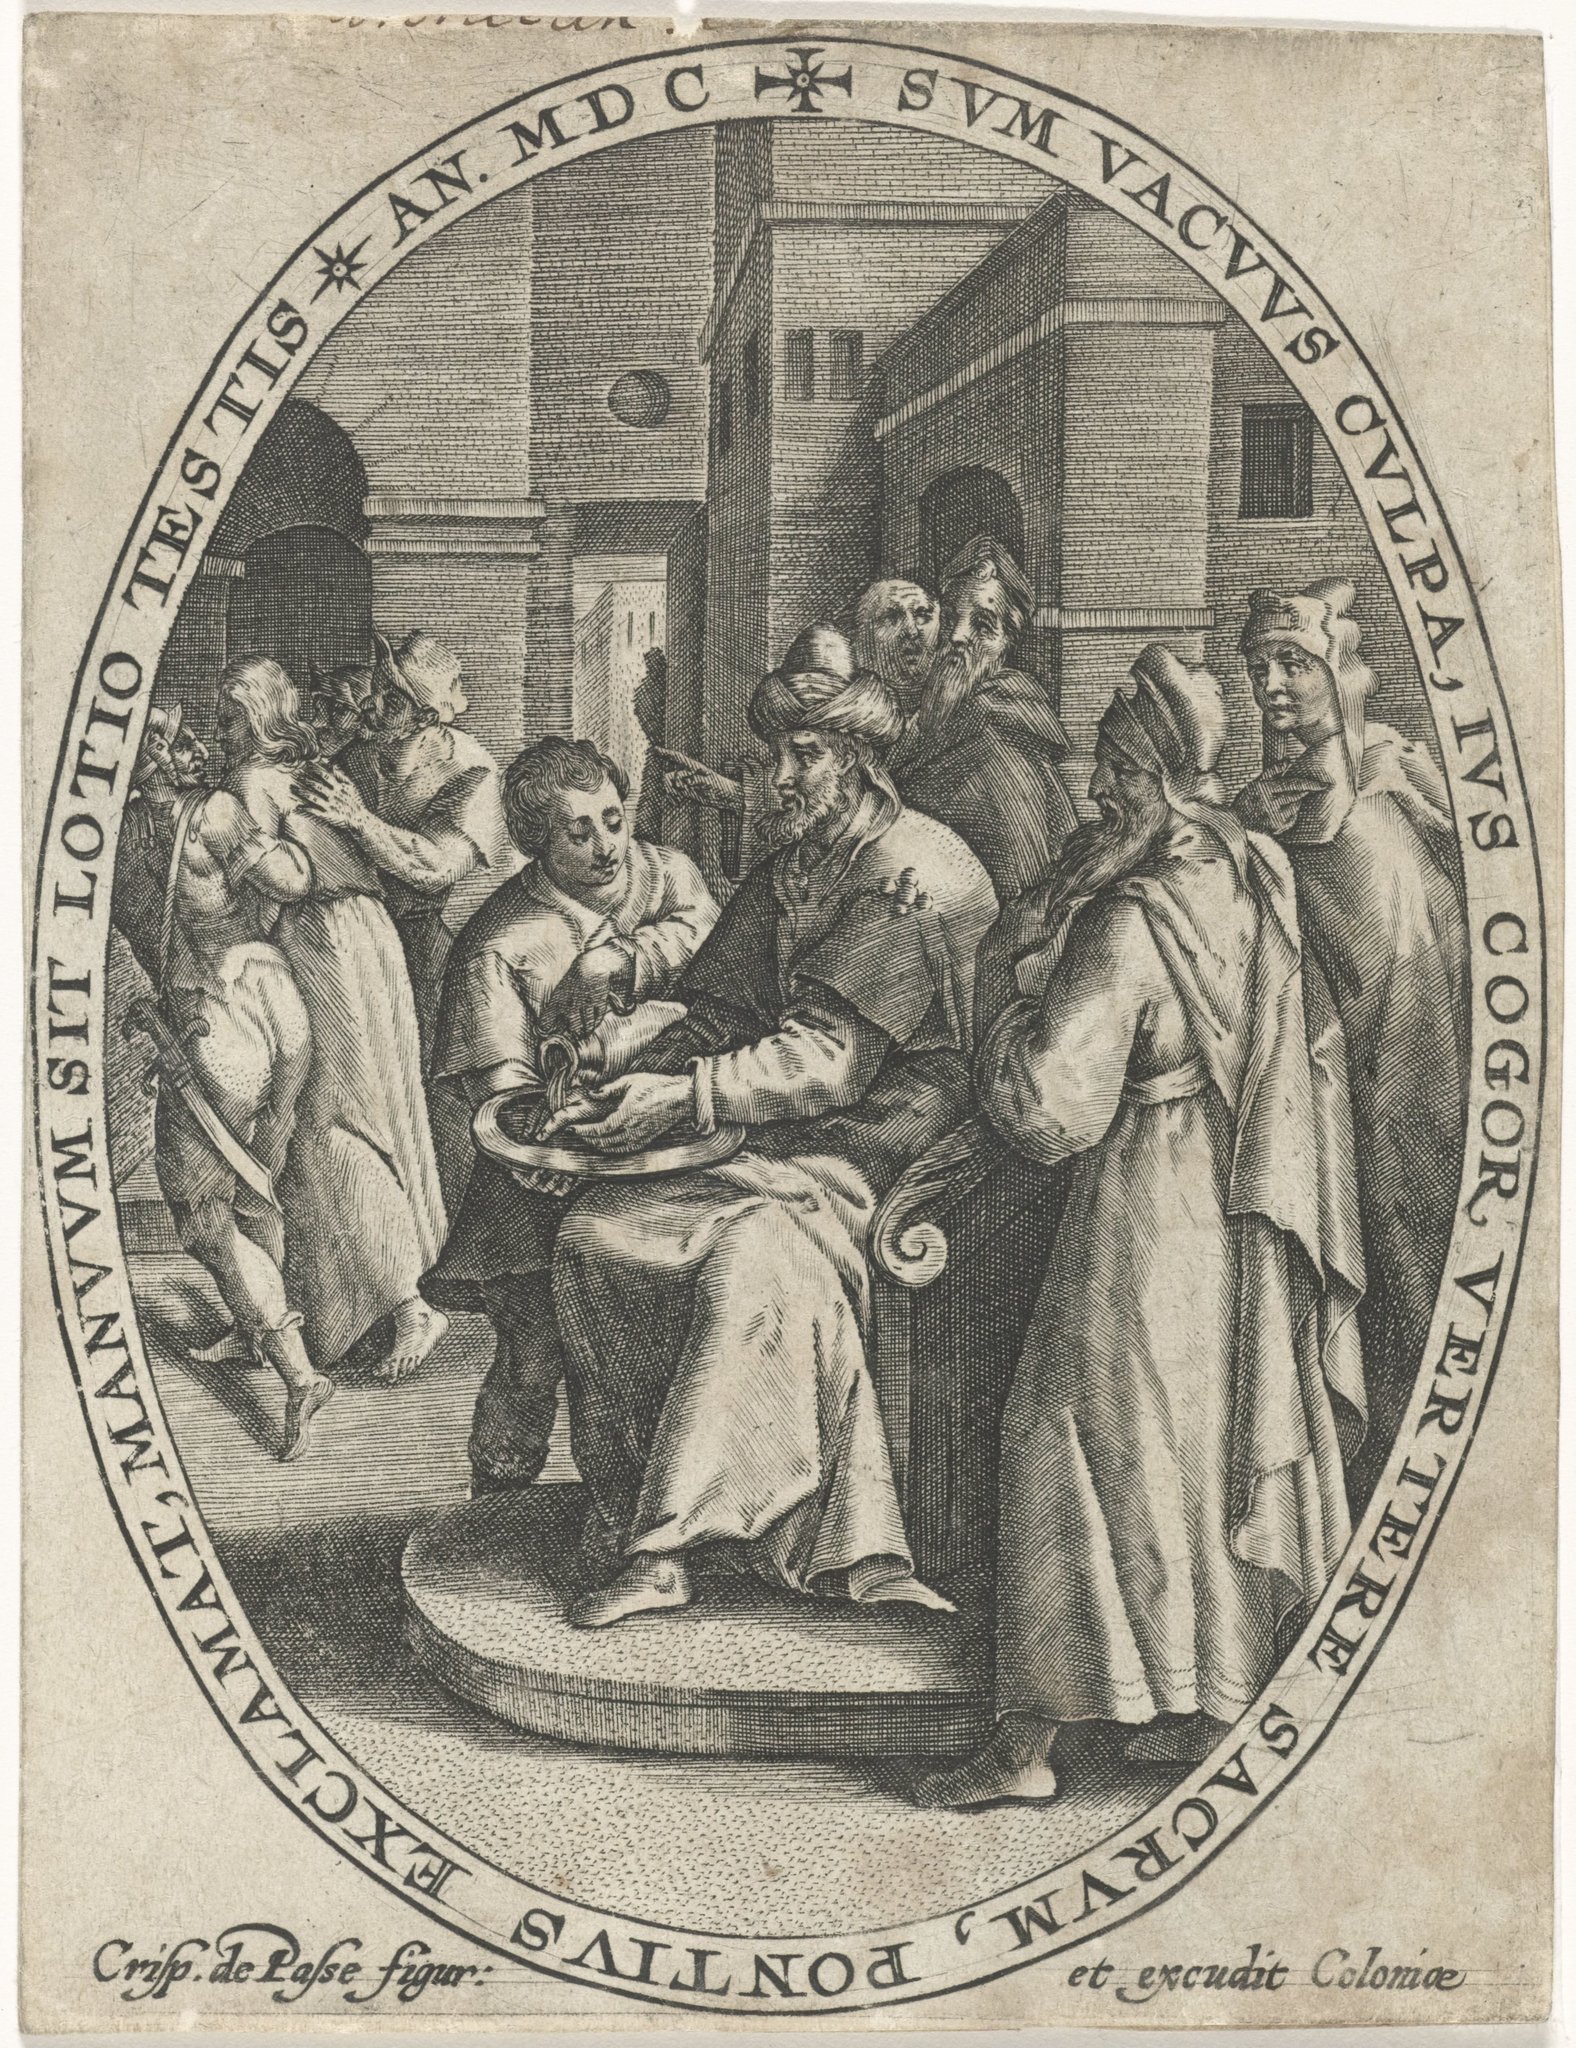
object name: print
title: Passio Domini nostri Jesu Christi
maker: crispijn van de passe (i)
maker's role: draughtsman, print maker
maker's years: 1564-1637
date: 1600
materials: paper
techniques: engraving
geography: cologne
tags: pilate washing his hands (in innocence)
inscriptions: collector's mark: Lugt 2228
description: Christus wordt ter dood veroordeeld en afgevoerd. Pilatus wast zijn handen in onschuld. De voorstelling is gevat in een ovale omlijsting met een randschrift in het Latijn. Prent uit een serie met de passie van Christus.